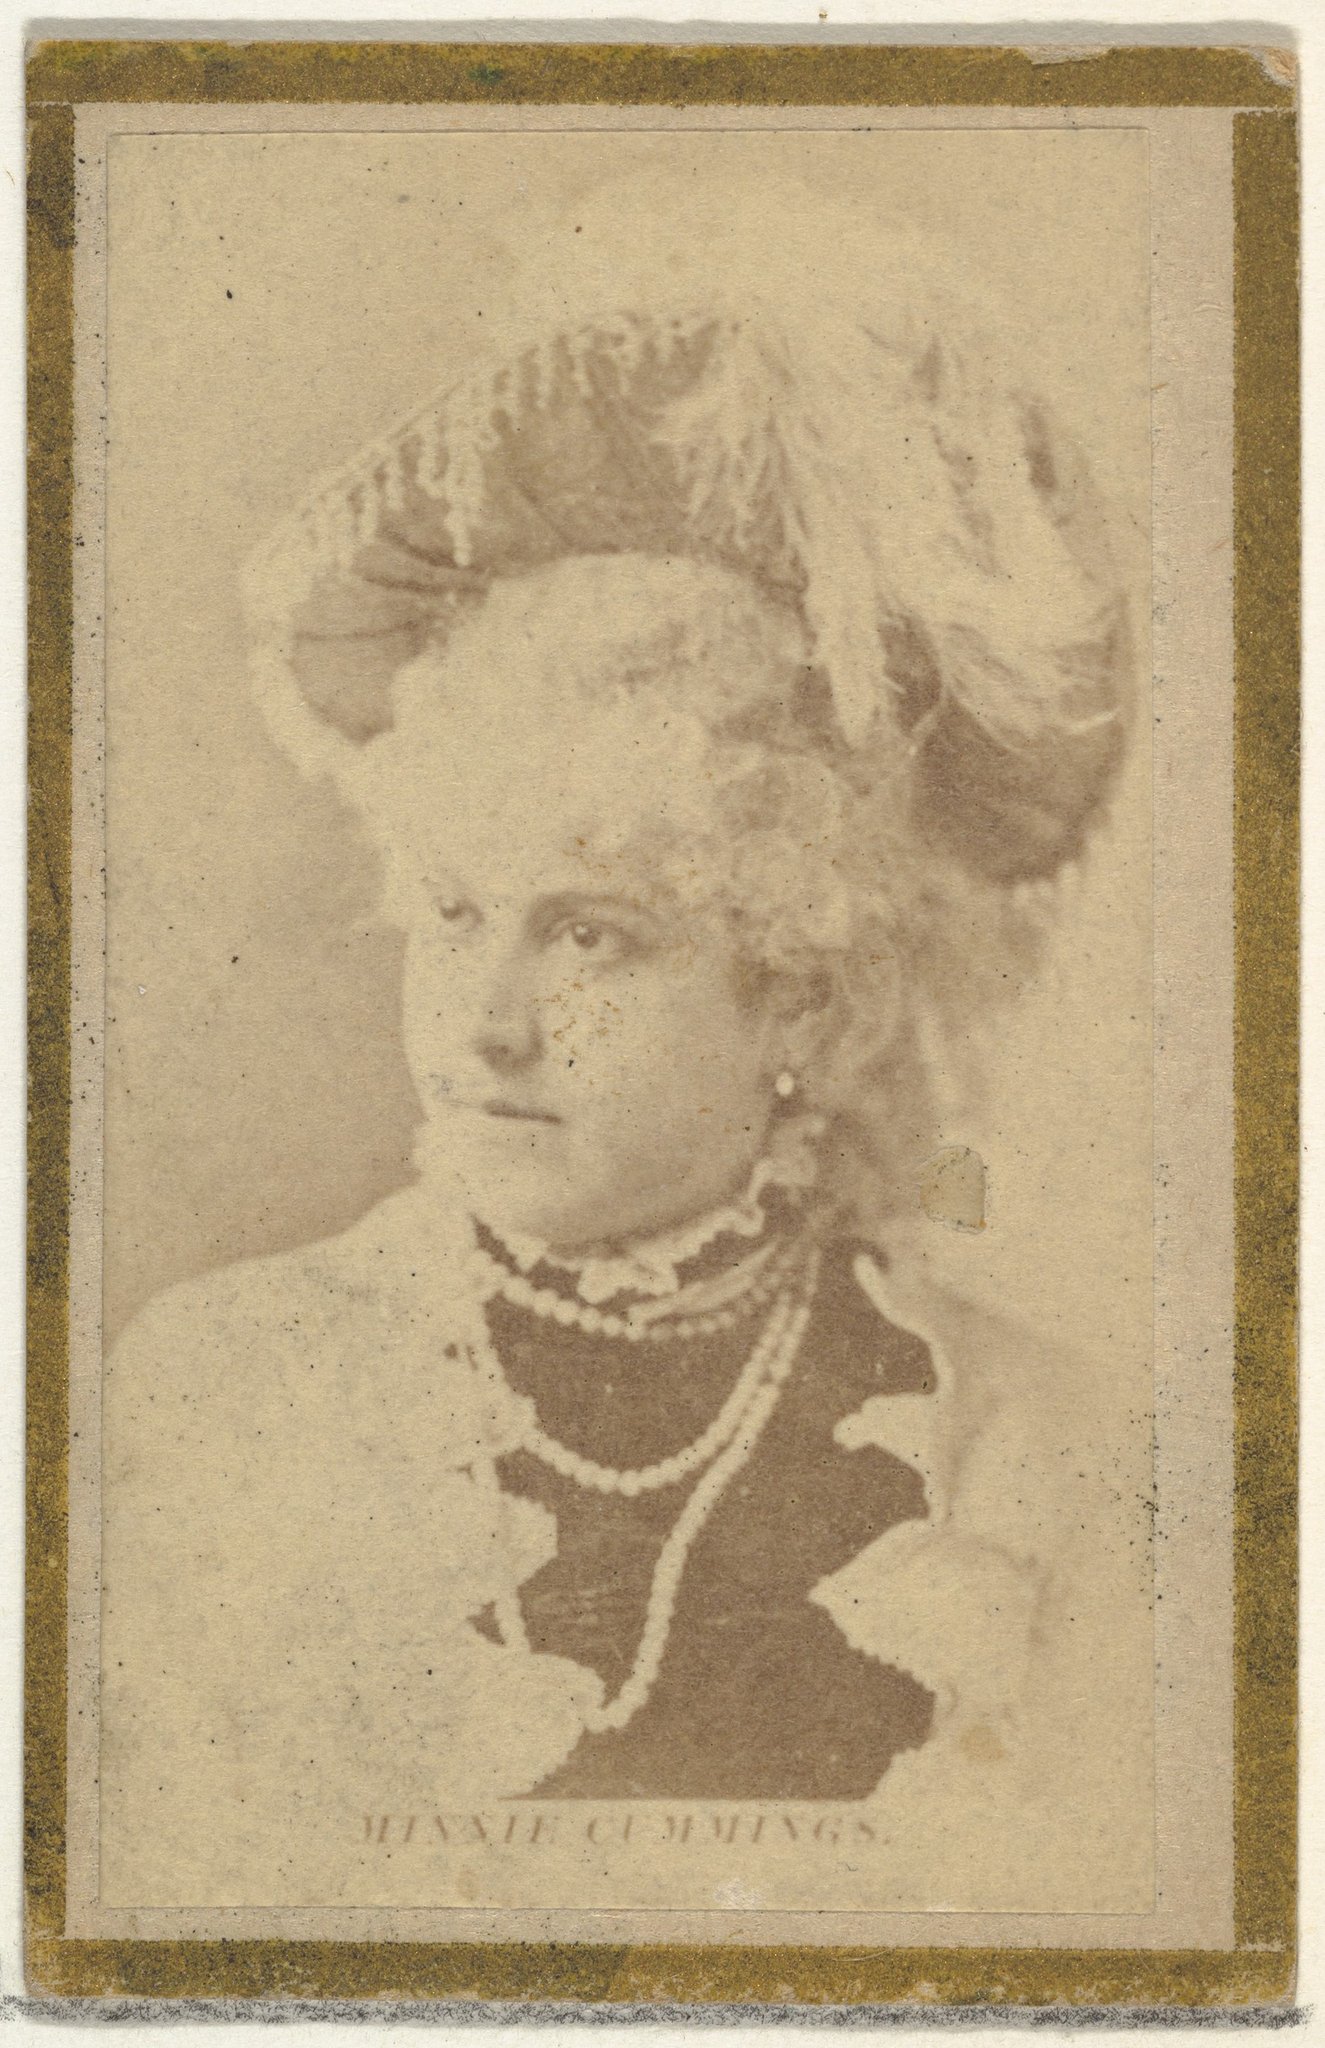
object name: photograph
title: Minnie Cummings, from the Actresses and Celebrities series (N60, Type 2) promoting Little Beauties Cigarettes for Allen & Ginter brand tobacco products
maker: allen & ginter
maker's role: publisher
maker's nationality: american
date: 1887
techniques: albumen silver print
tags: portraits,women,actresses